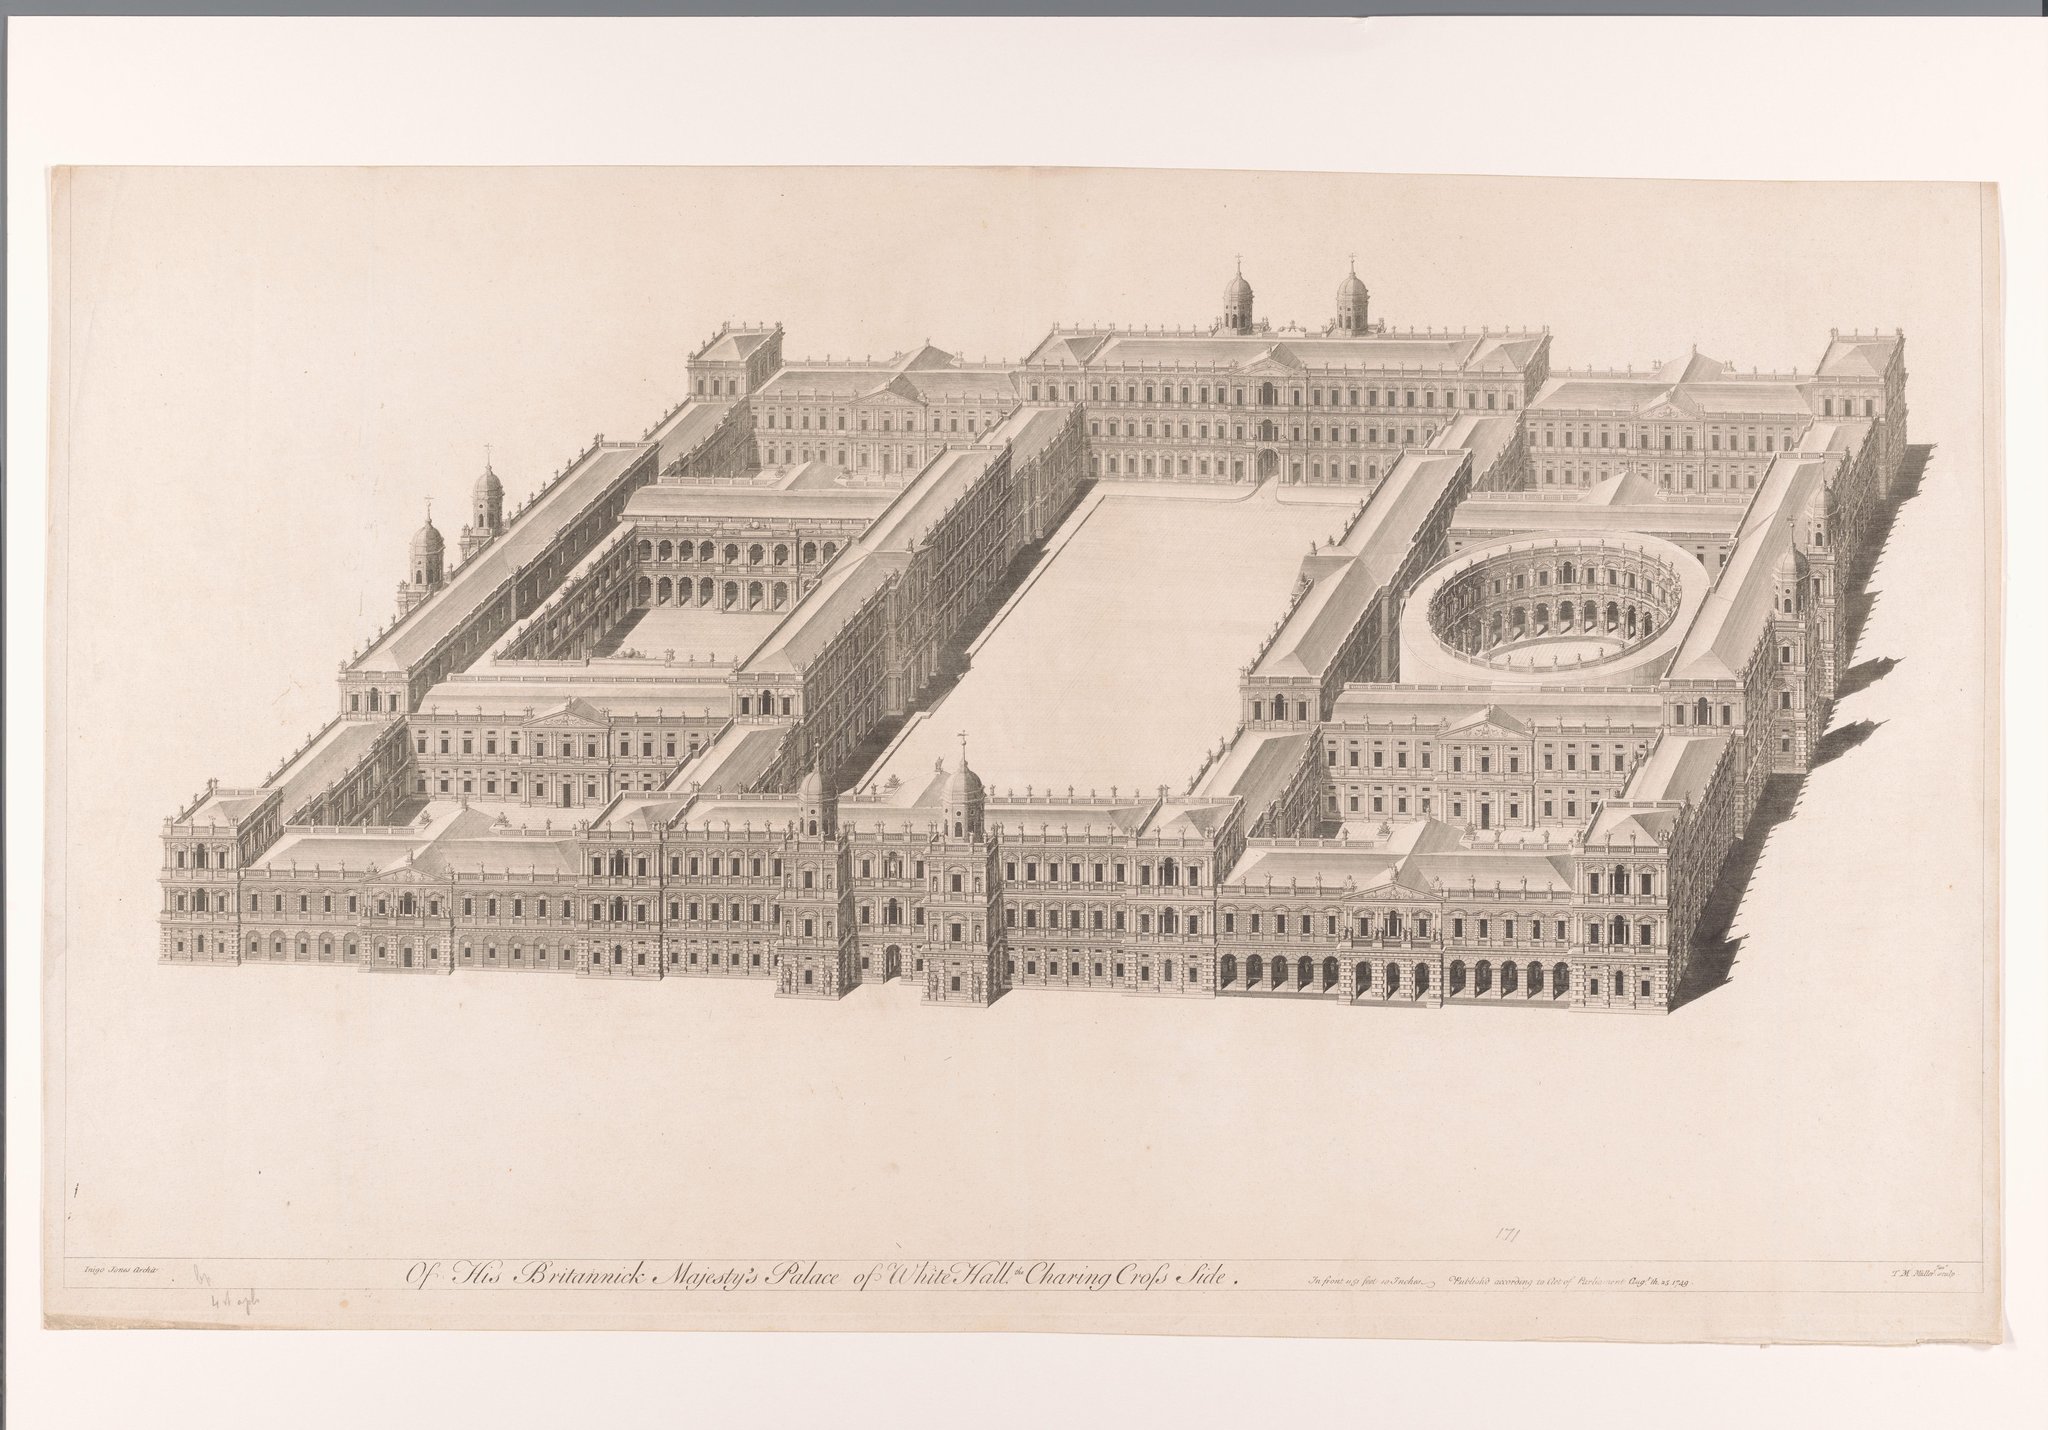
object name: print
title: Inigo Jones archit. of his Britannick Majesty's Palace of White Hall (...)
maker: tobias müller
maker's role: print maker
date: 1749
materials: paper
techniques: etching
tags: palace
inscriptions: collector's mark: Lugt 2228